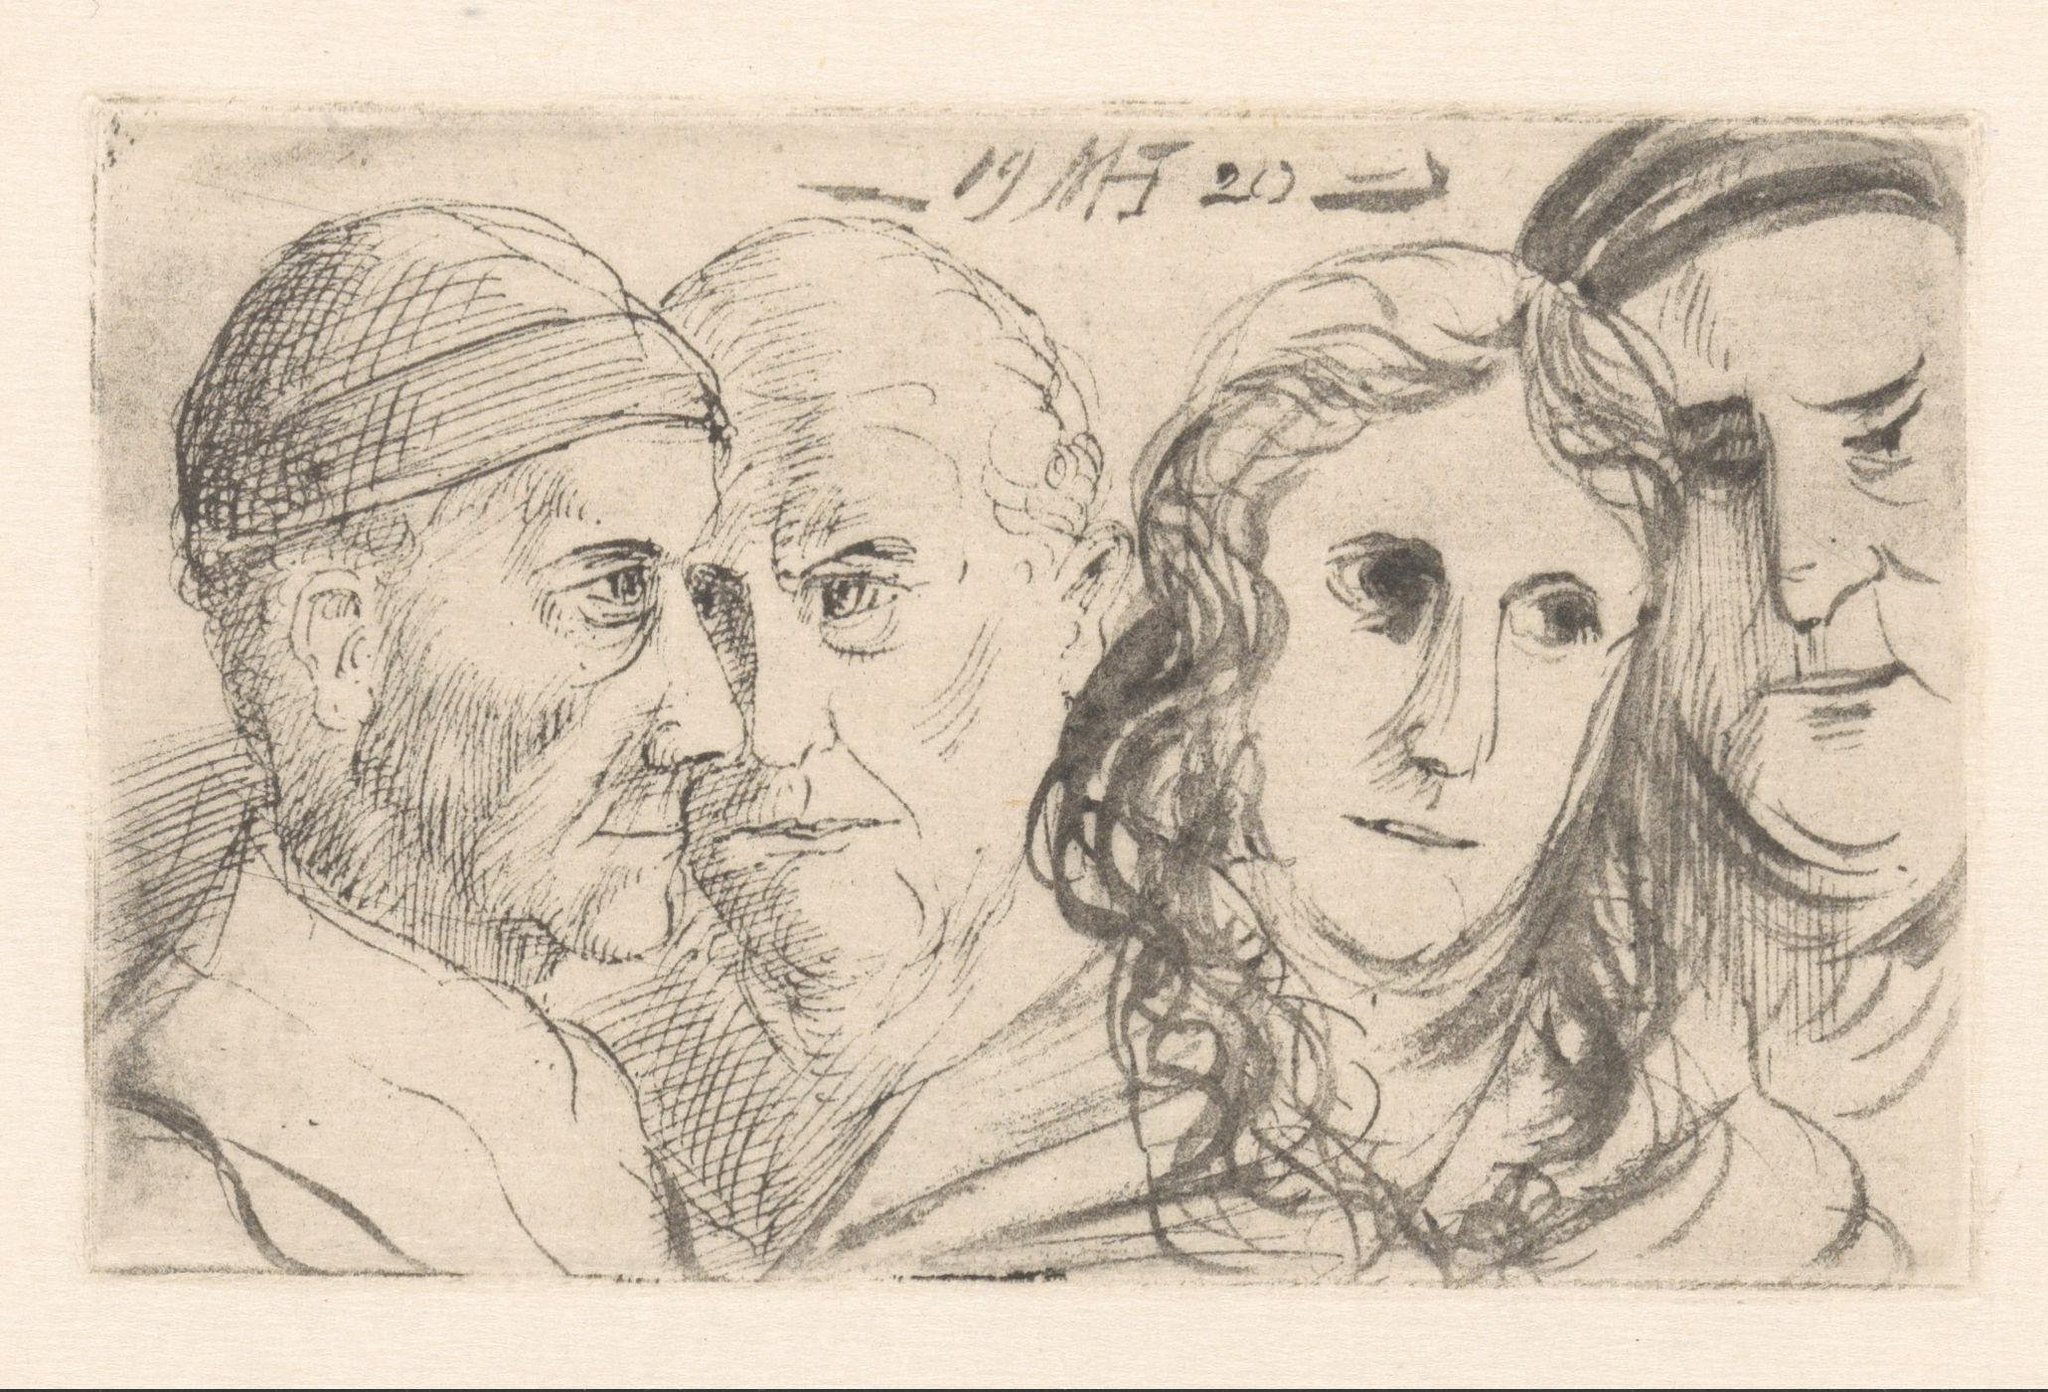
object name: print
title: Drie mannenhoofden en een vrouwenhoofd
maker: marius holleman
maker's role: draughtsman, print maker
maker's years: 1878-1926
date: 1920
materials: paper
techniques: etching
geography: groningen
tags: head-gear: hat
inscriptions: collector's mark: Lugt 2228